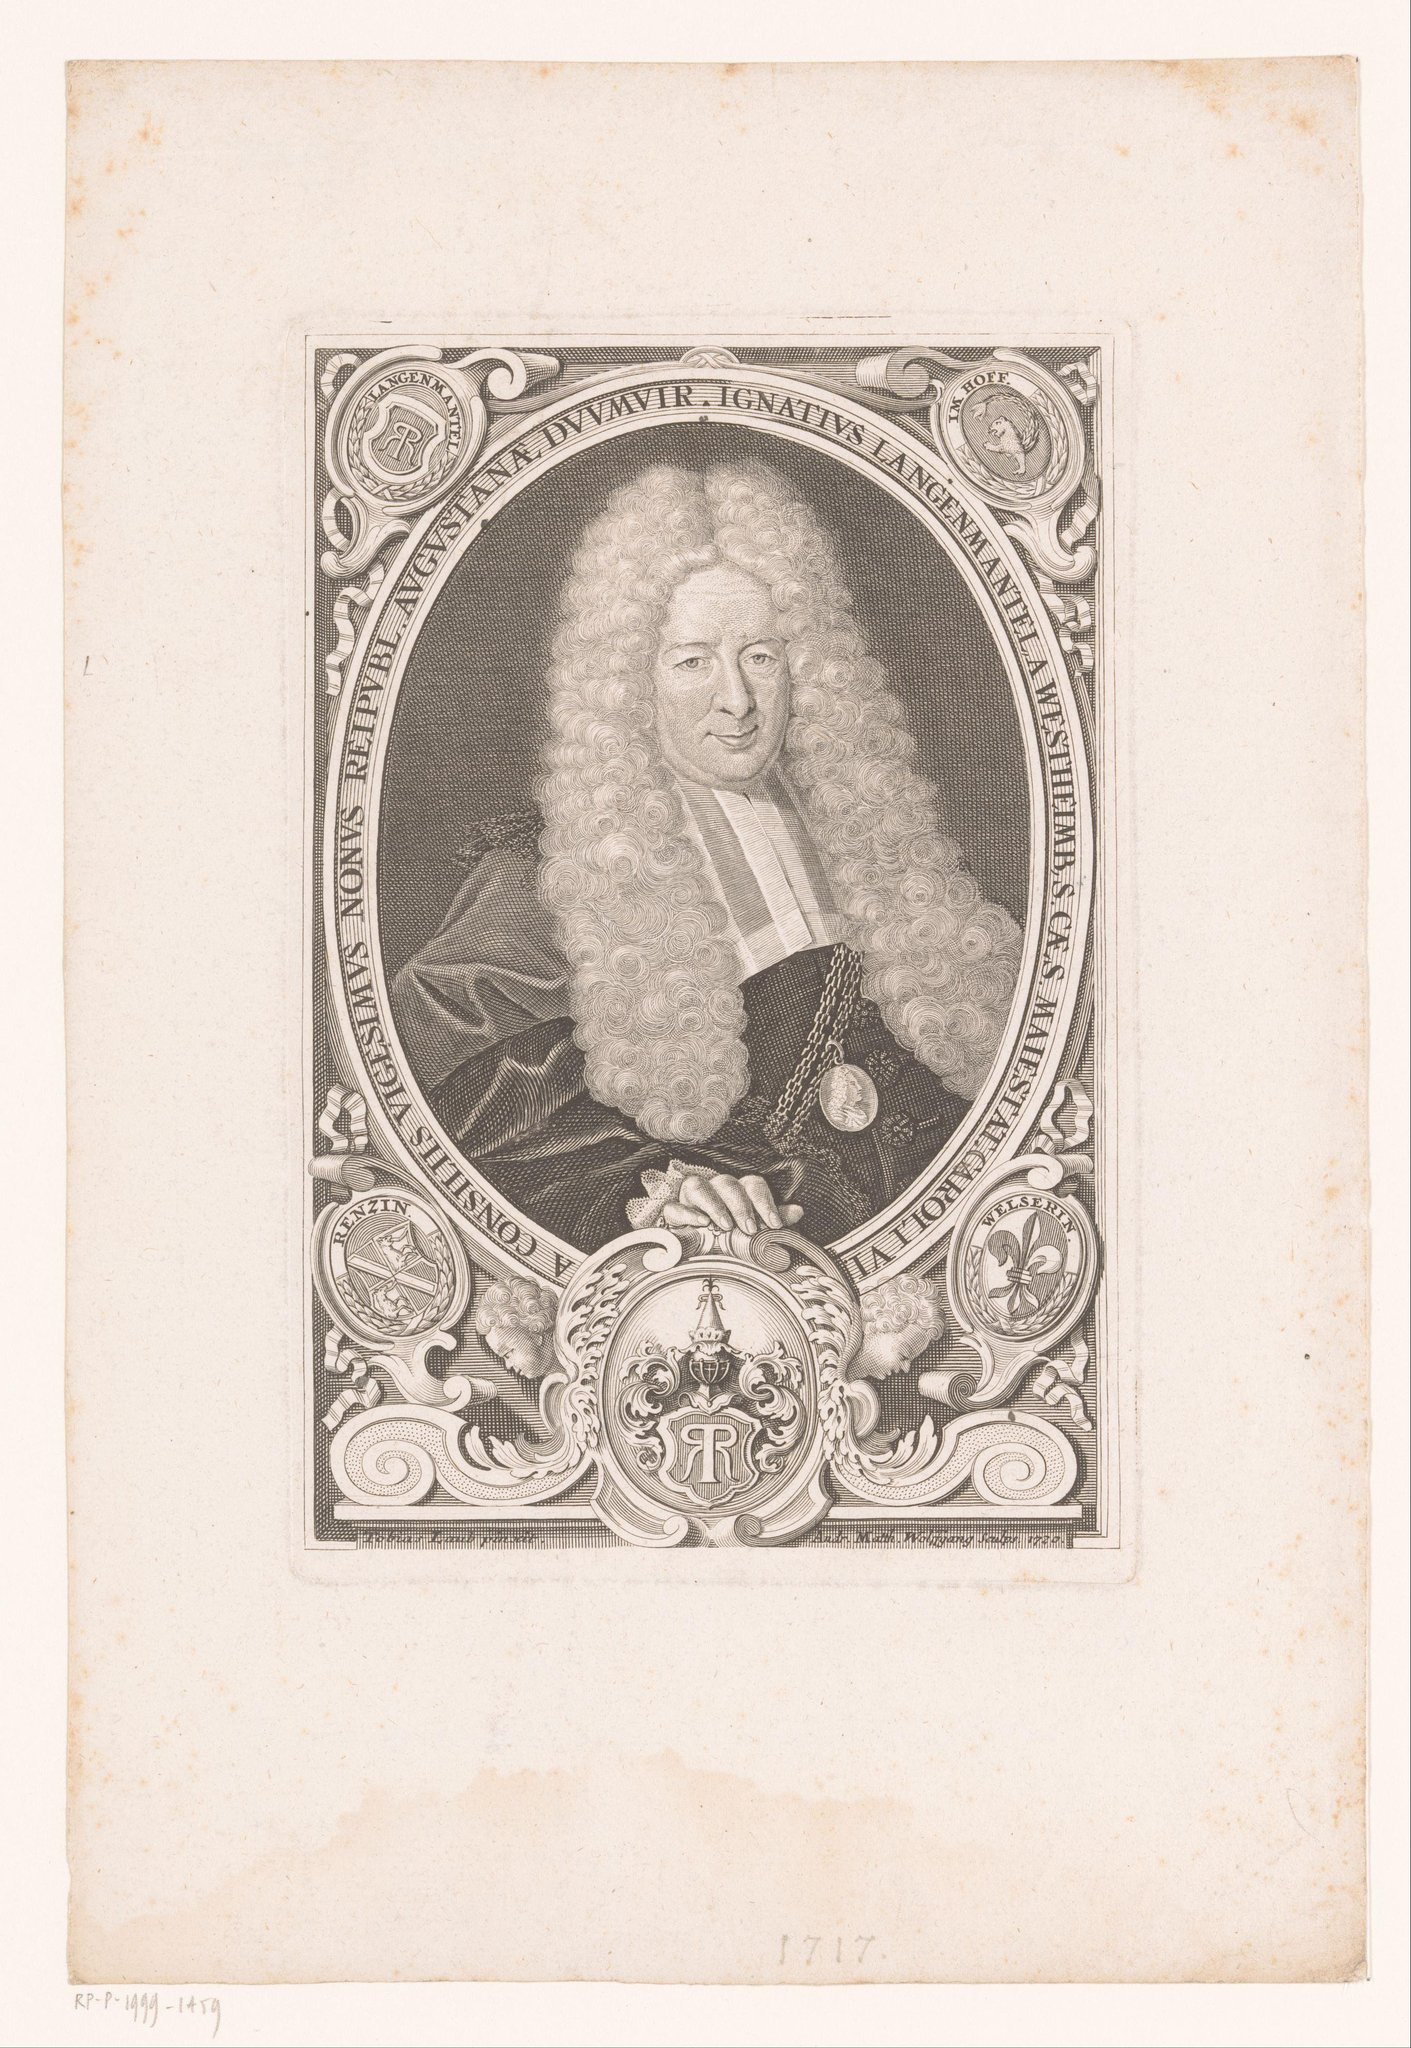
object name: print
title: Portret van Ignatius Langenmantel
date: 1720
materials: paper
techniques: engraving, etching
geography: germany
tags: historical persons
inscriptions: collector's mark: Lugt 2228, collector's mark: Lugt 2760